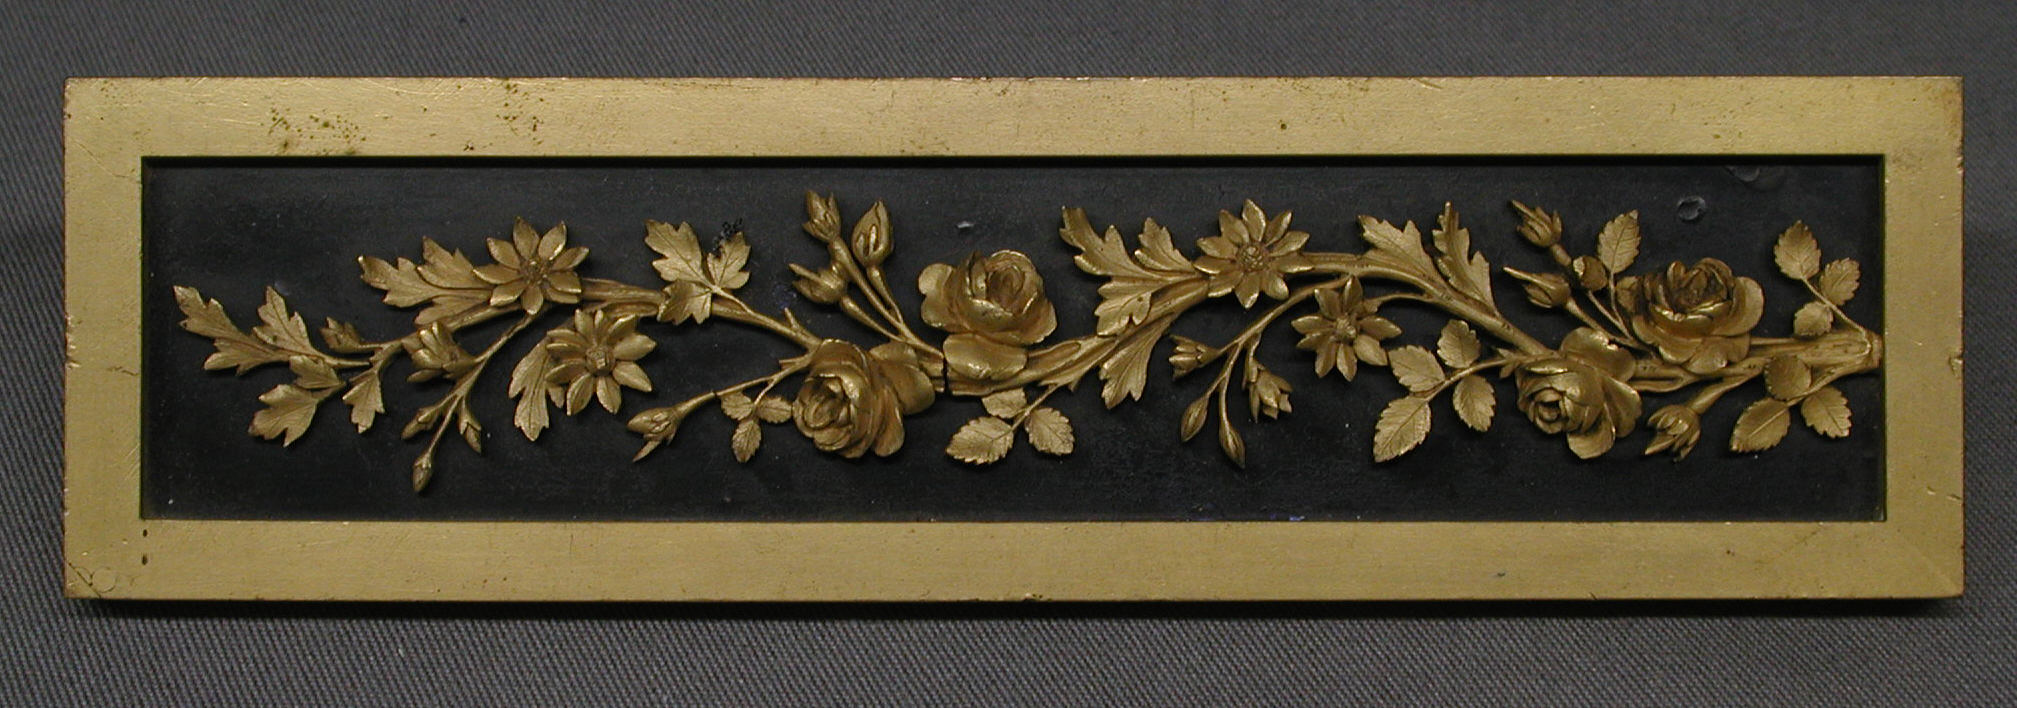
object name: ornament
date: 1701-1800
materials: enamel, gilt bronze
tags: roses,leaves